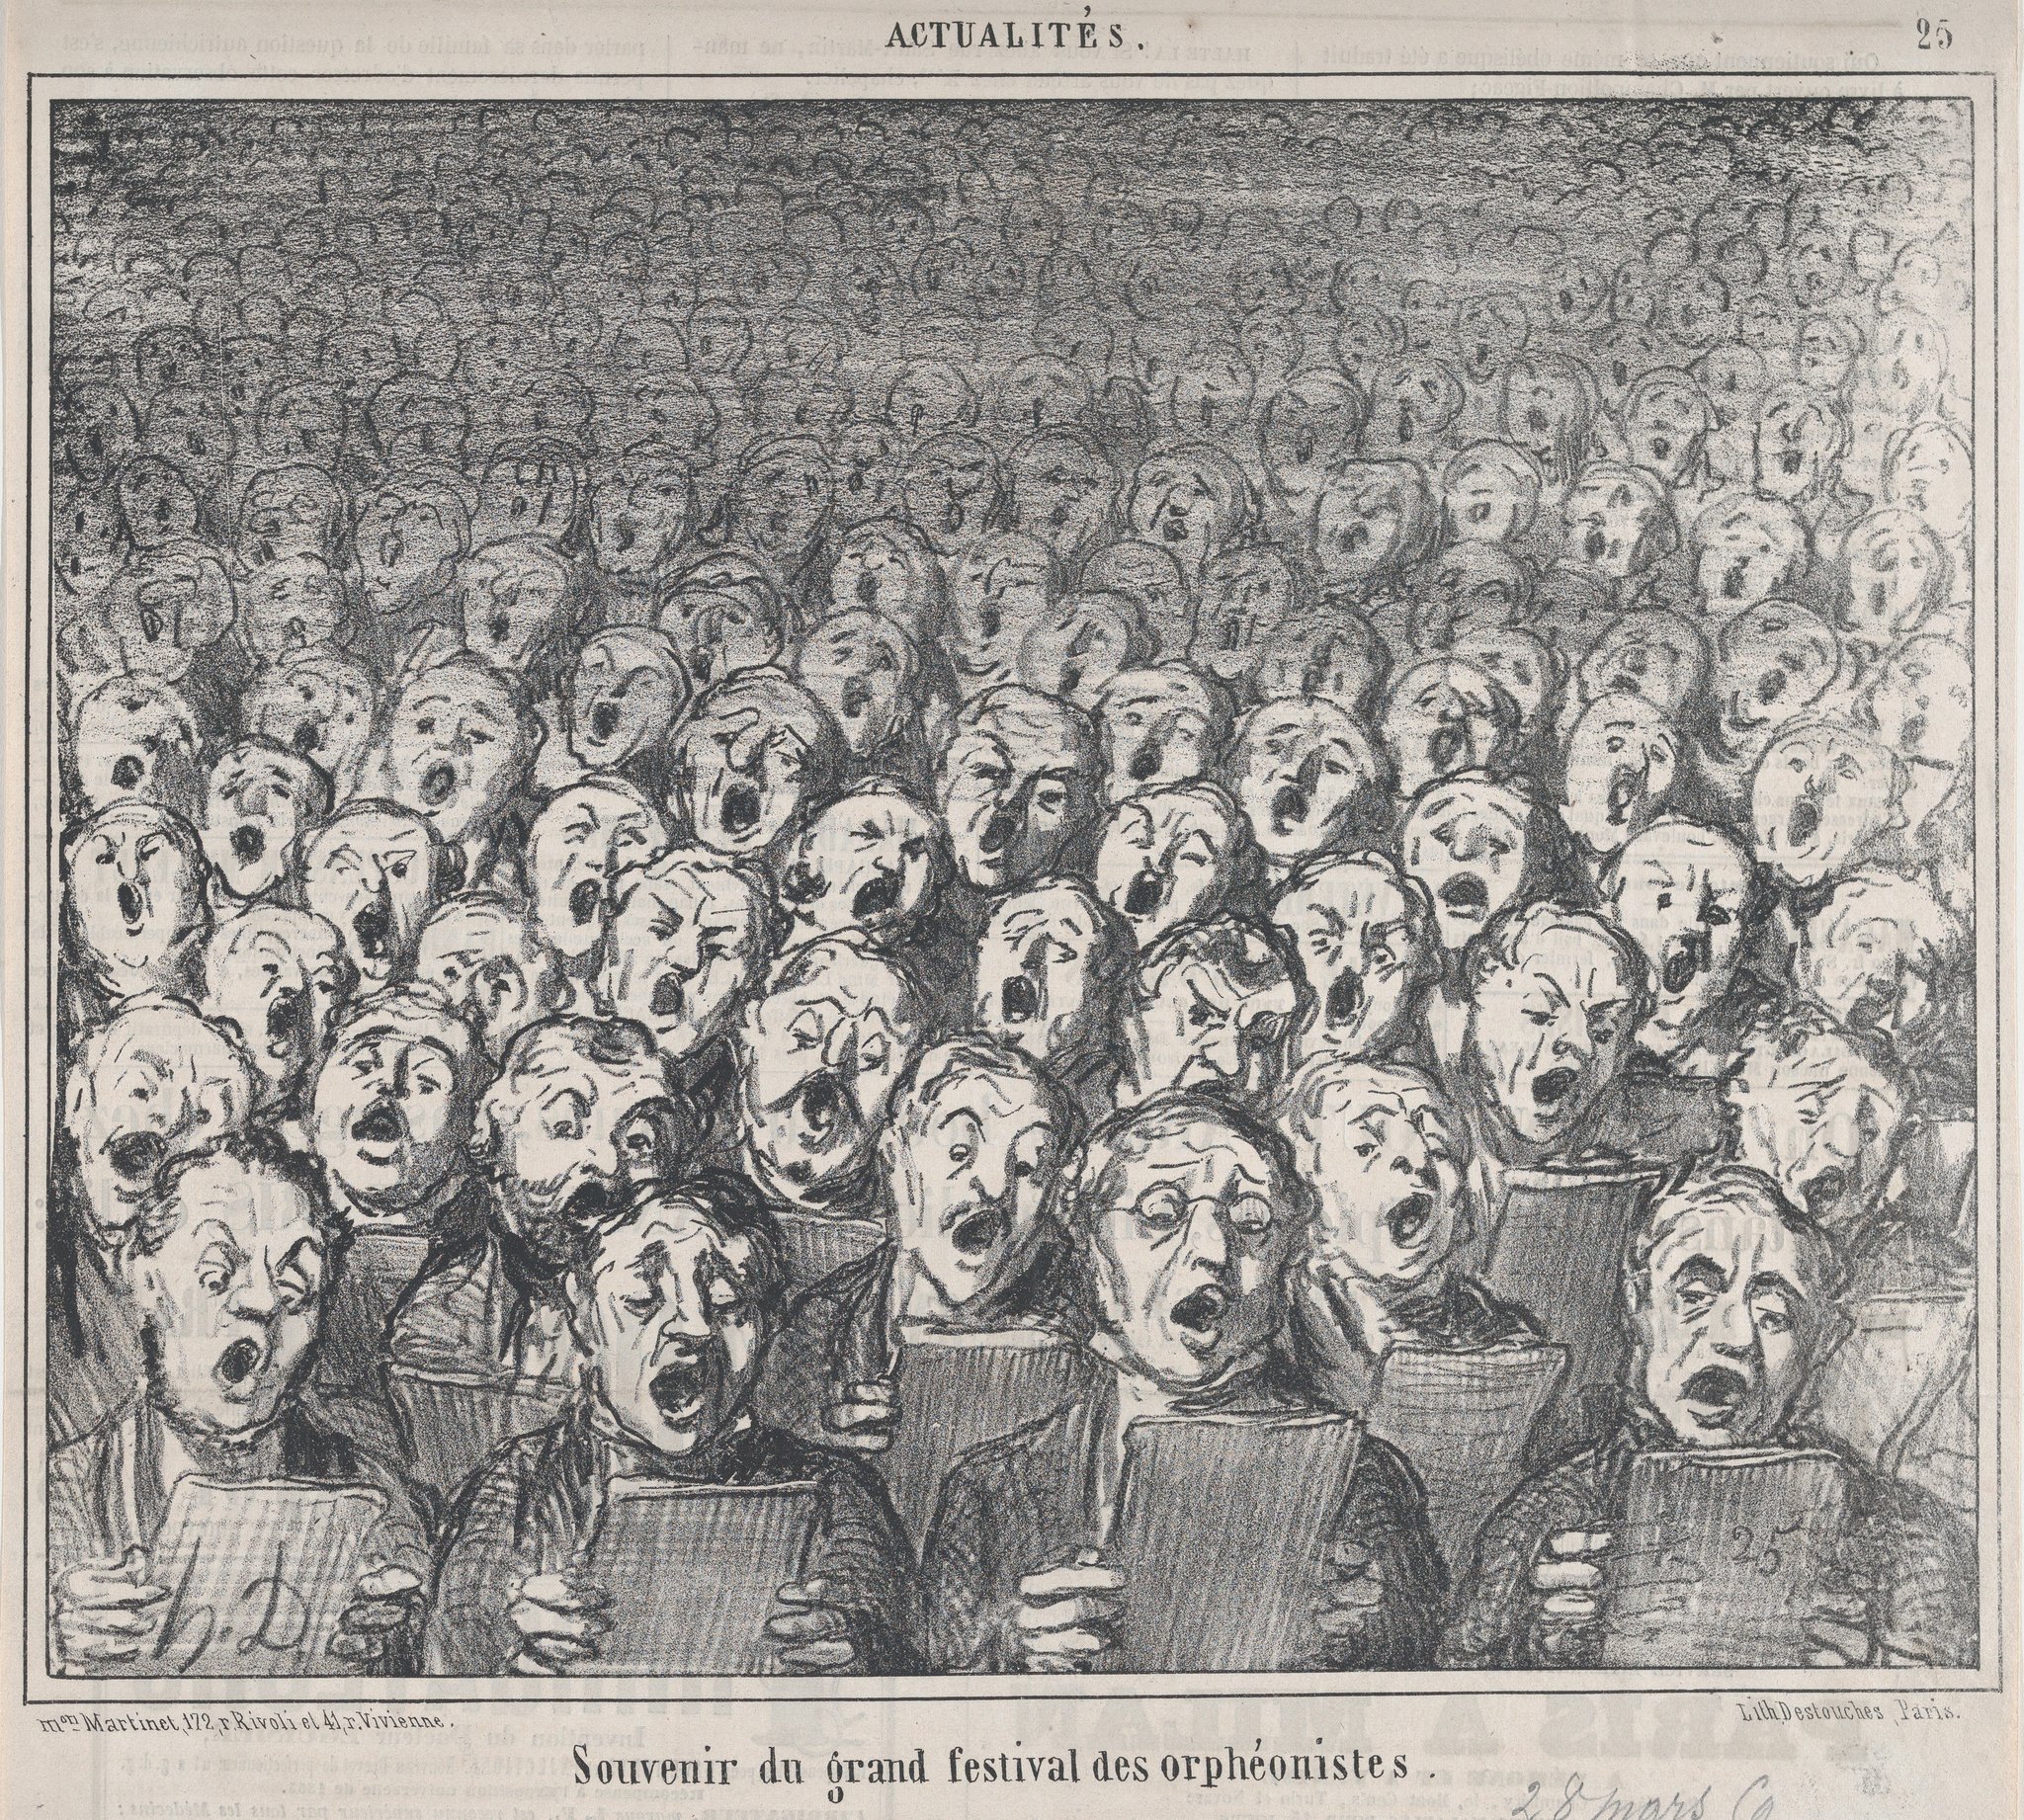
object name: print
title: Souvenir du grand festival des orphéonistes, from Actualités, published in Le Charivari, March 28, 1859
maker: honoré daumier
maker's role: artist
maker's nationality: french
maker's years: 1808-1879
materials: paper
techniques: lithograph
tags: men,crowd